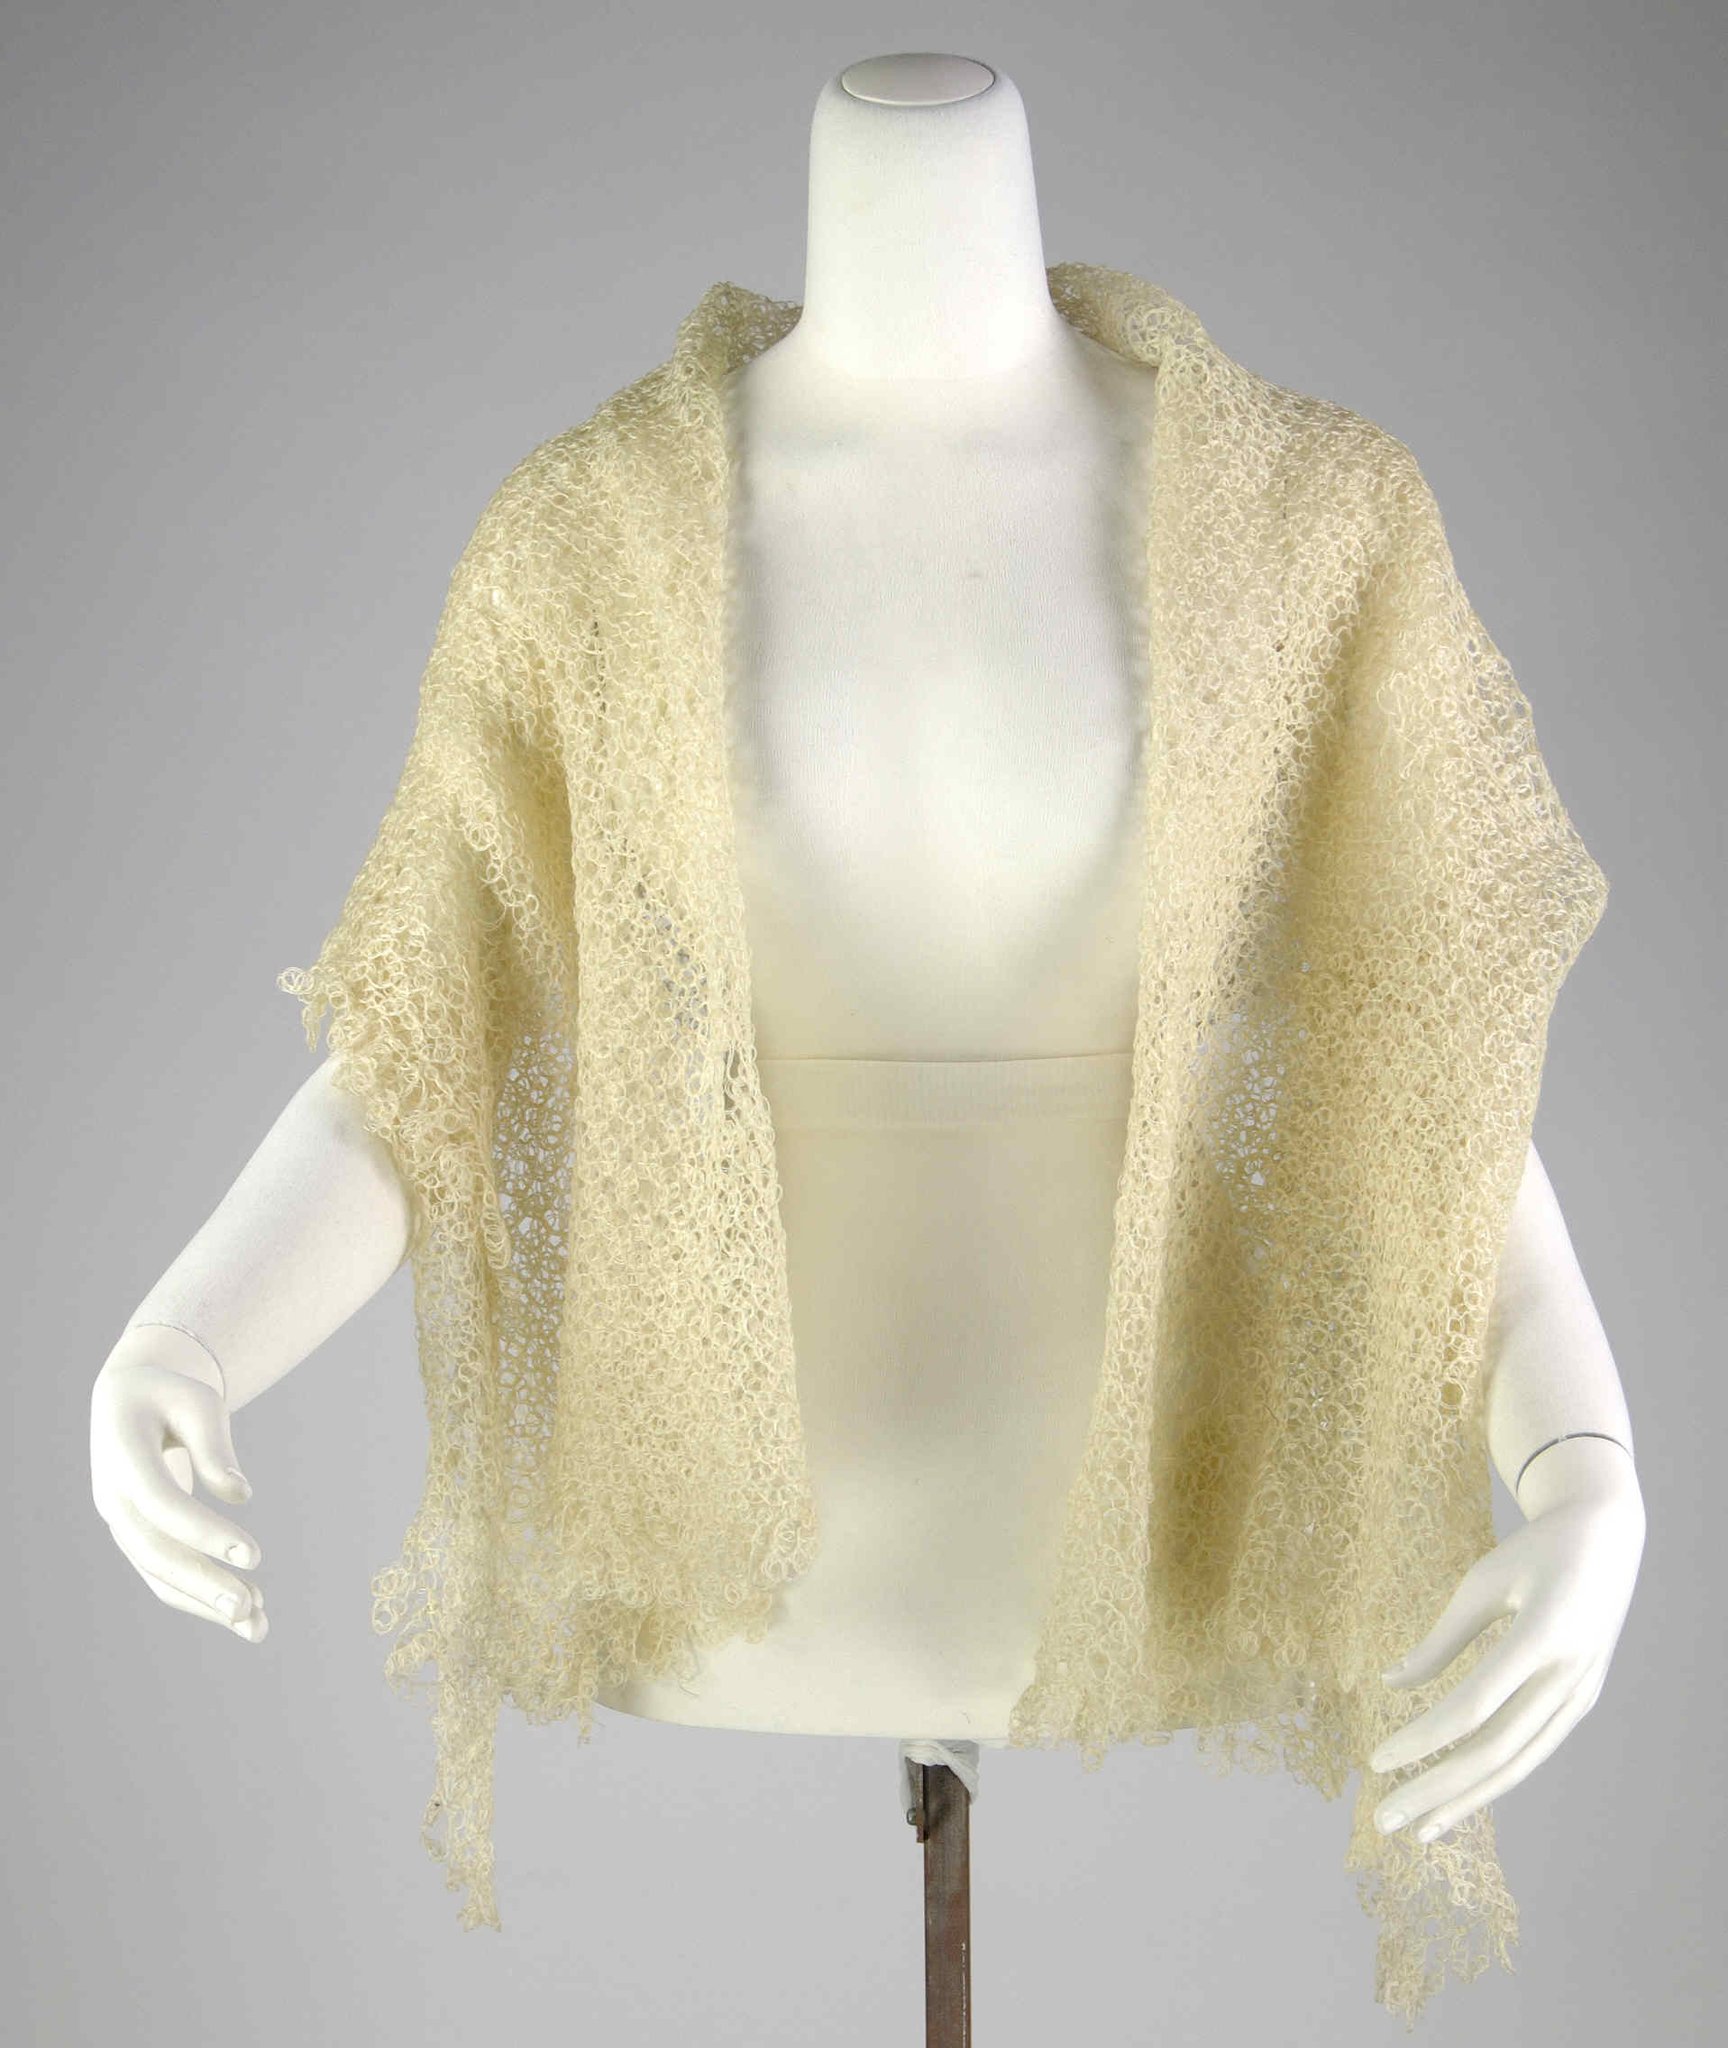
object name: stole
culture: american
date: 1850-1860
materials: wool